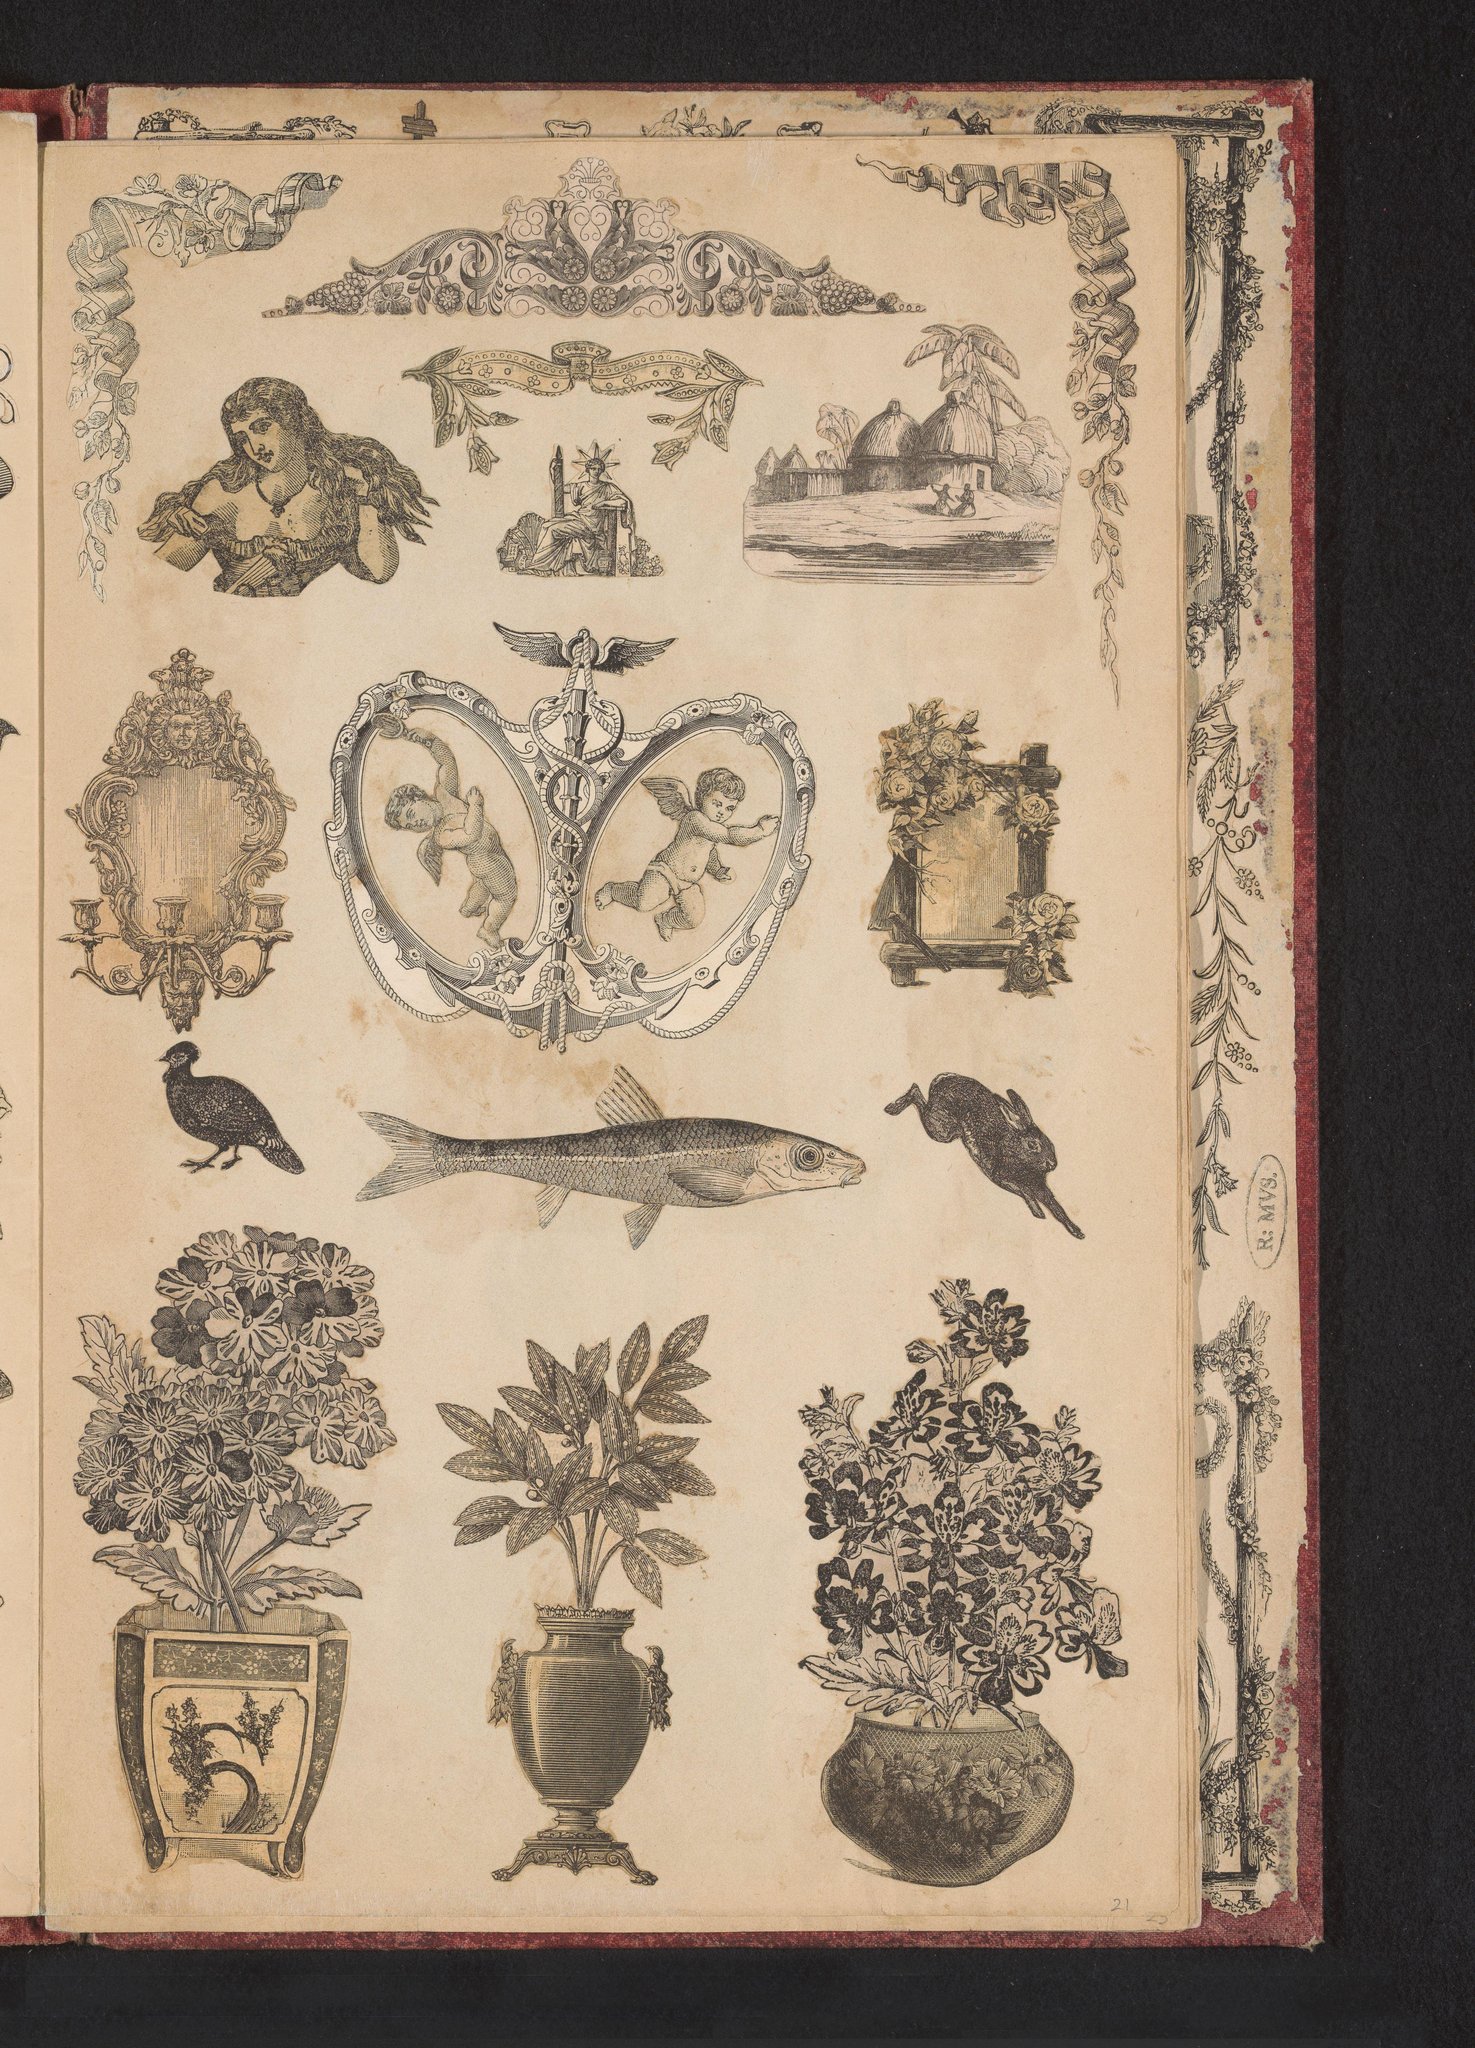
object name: print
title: Collage van uitgeknipte prenten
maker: Anonymous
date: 1870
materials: paper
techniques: engraving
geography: paris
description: Collage van uitgeknipte prenten. Onderdeel van een album met 32 bladen, aan beide zijden beplakt met uitgeknipte prenten, vermoedelijk afkomstig uit 19e-eeuwse tijdschiften.